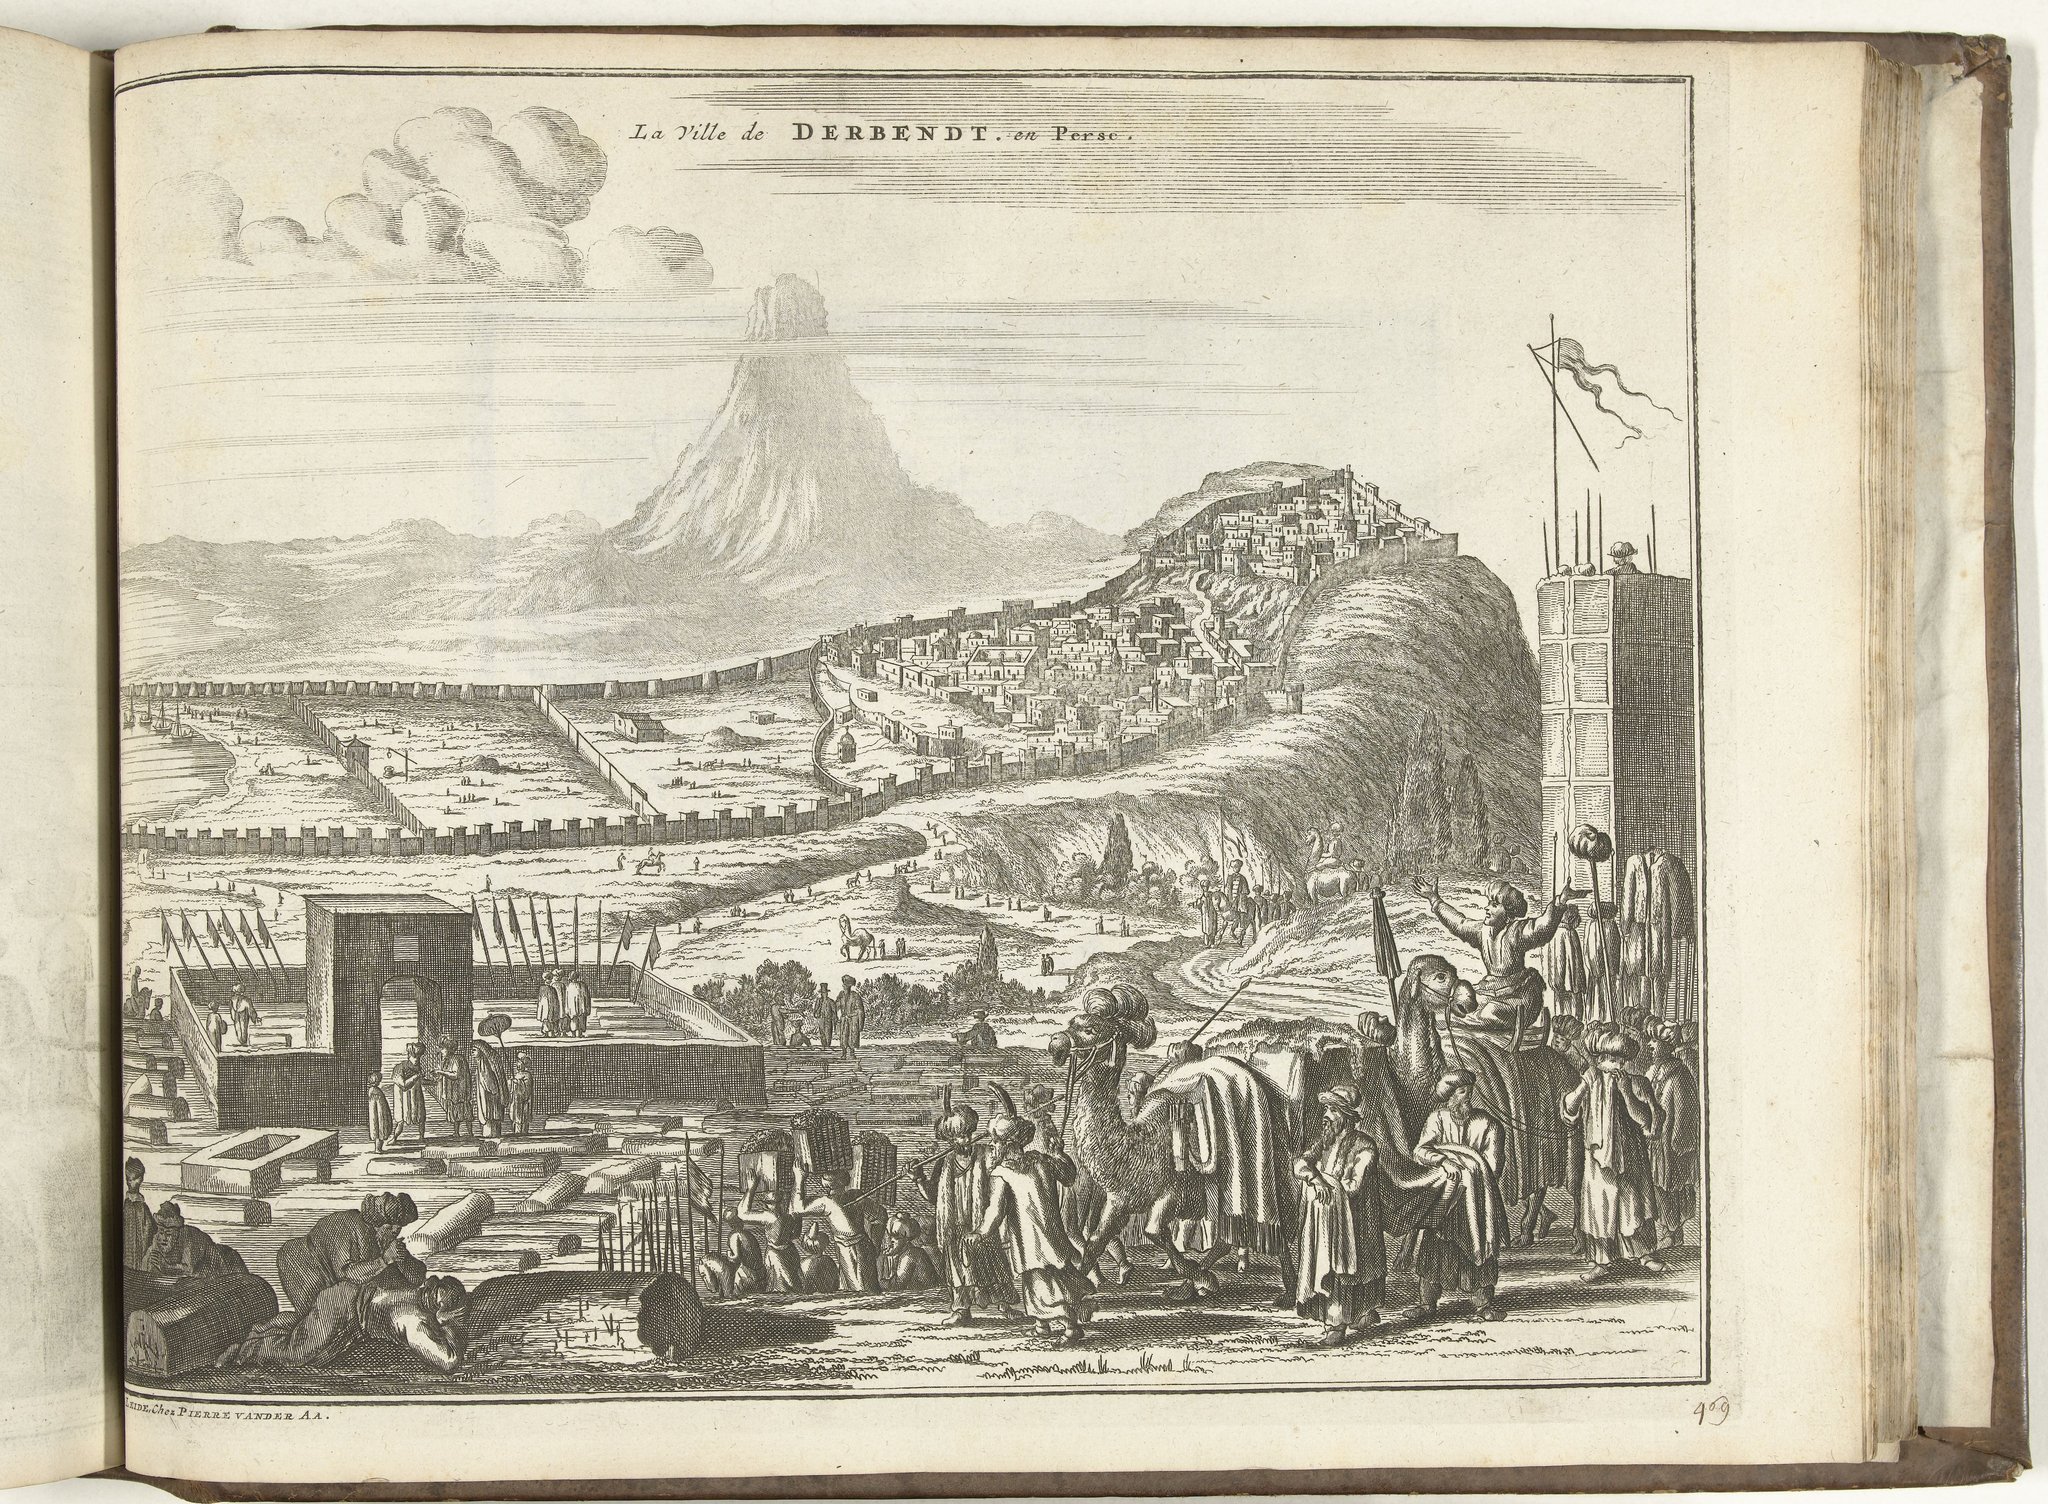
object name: print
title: La Ville de Derbendt, en Perse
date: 1726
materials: paper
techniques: engraving, etching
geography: leiden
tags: cortege, funeral procession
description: Gezicht op Derbent in Perzië, op de voorgrond begrafenisoptocht onderweg naar een begraafplaats. Plaat nr. 469 in deel XIX van het prentwerk: Les Forces de l'Europe, Asie, Afrique et Amerique ... Comme aussi les Cartes des Côtes de France et d'Espagne uit 1726, dit tweede deel met 271 met de hand genummerde platen van vermaarde sterke steden en vestingen in het kader van de Spaanse Successieoorlog 1701-1713. Voor het merendeel zijn deze platen gekopieerd naar de anonieme Franse platen van vermaarde sterke steden en vestingen: in Les forces de l'Europe en in: Le theatre de la guerre, dans les Pays-Bas, beide oorspronkelijk uitgegeven door Nicolas de Fer te Parijs (1693-1697) in het kader van de Negenjarige Oorlog. Titel in het Frans.